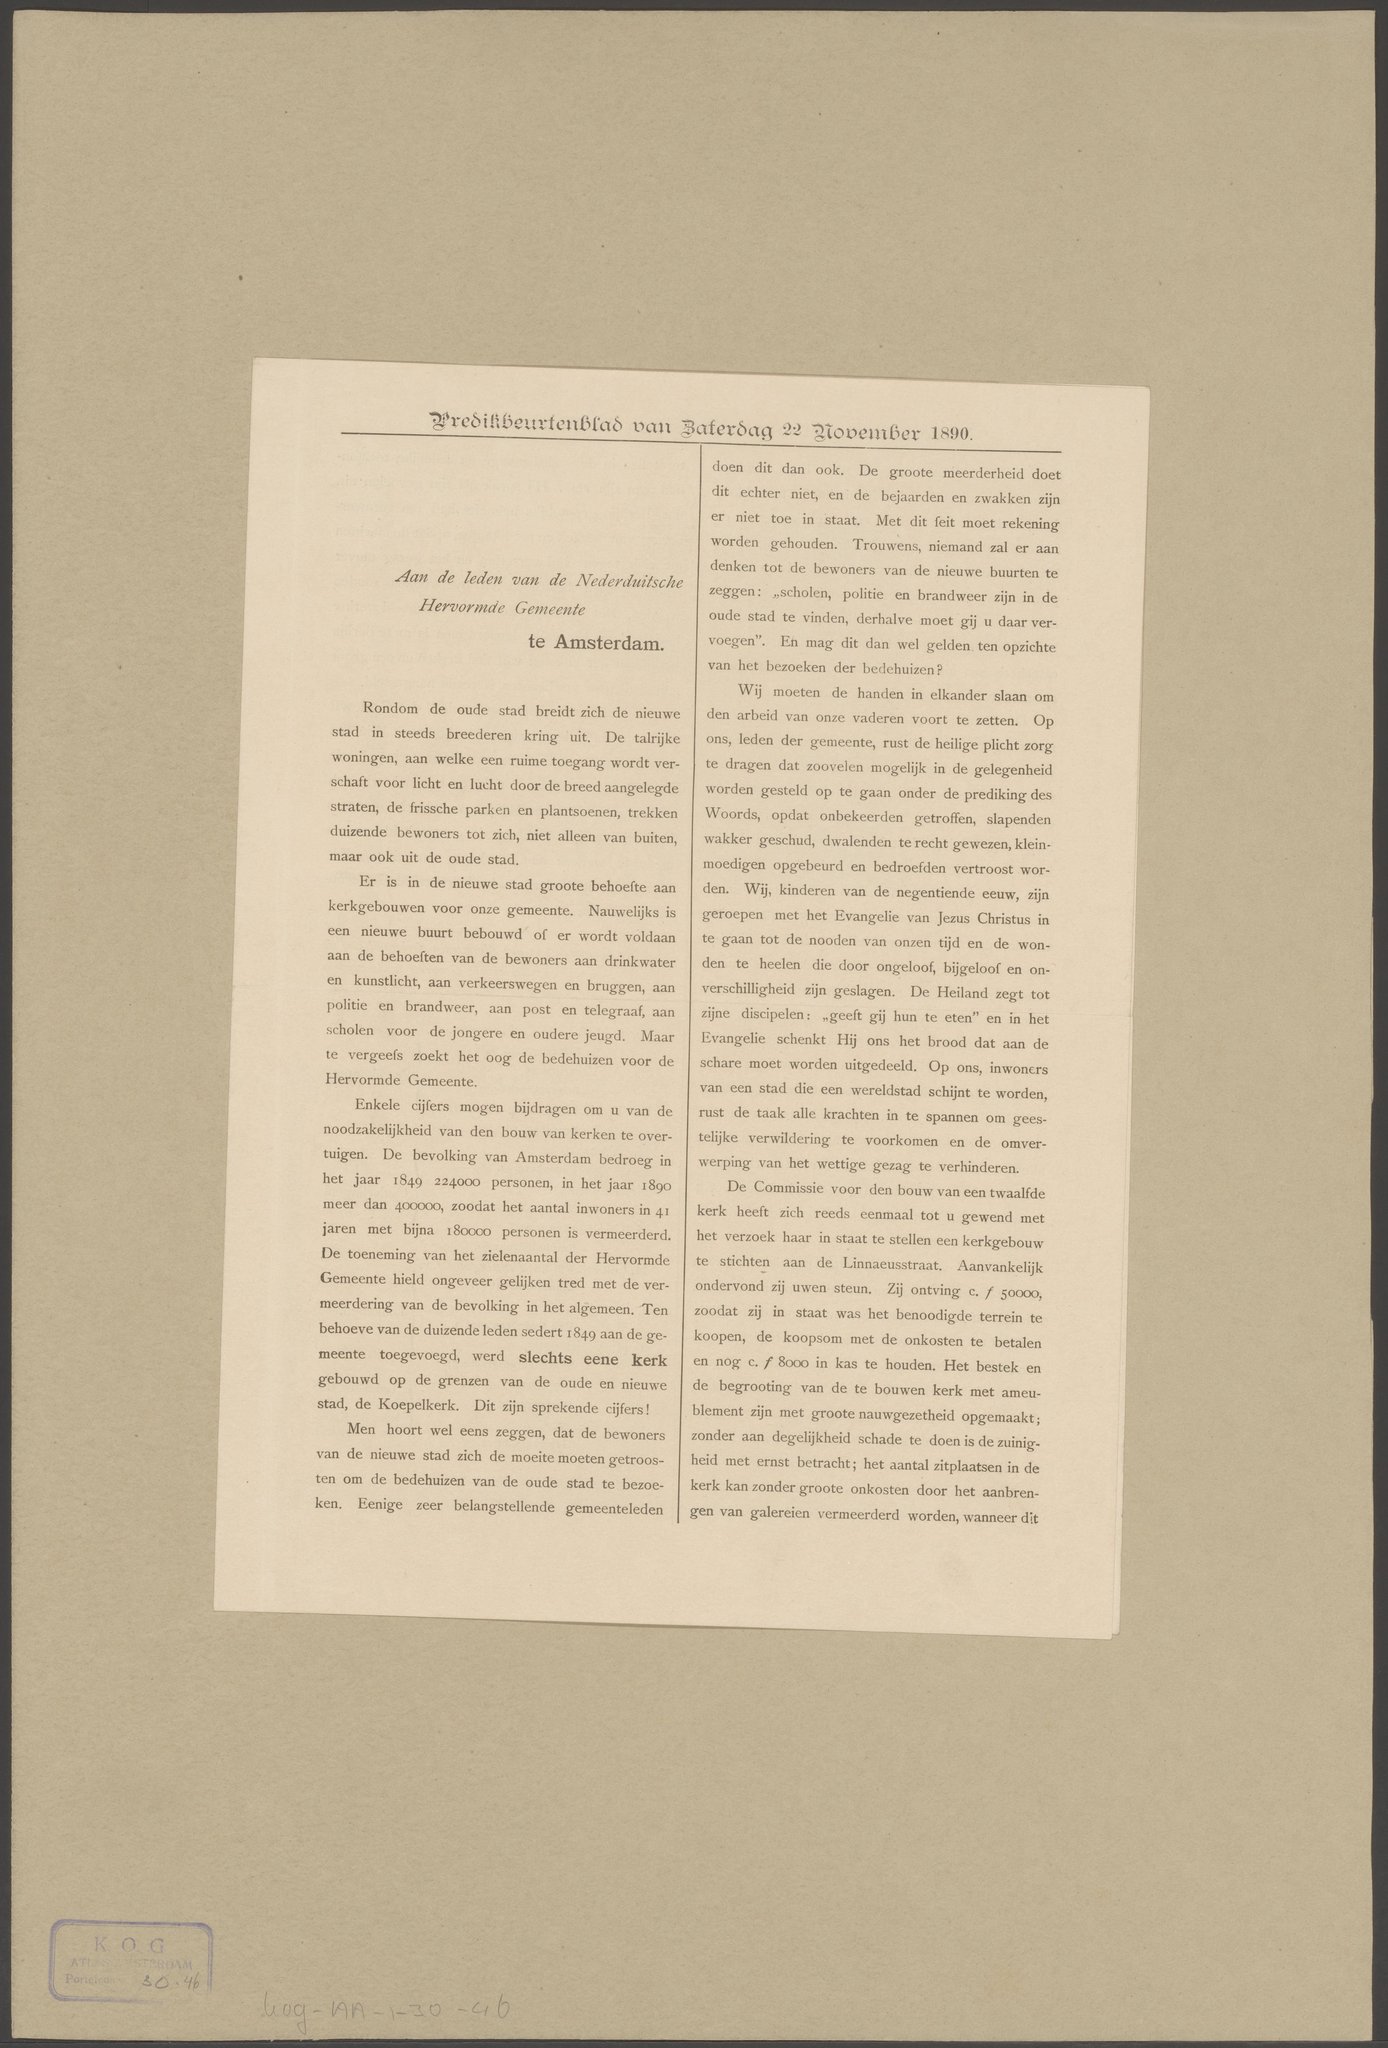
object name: photomechanical print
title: Oproep tot giften voor de bouw van de Muiderkerk te Amsterdam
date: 1890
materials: paper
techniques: letterpress printing, line block, printing block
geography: netherlands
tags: church (exterior)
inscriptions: collector's mark: Lugt 1641b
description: Object bestaat uit vier pagina's, waarvan de laatste leeg is. Onderwerpsrubriek binnen de Atlas Amsterdam: Kerkwezen: Hervormde Gemeente: Koepelkerk (Leidsebosje).